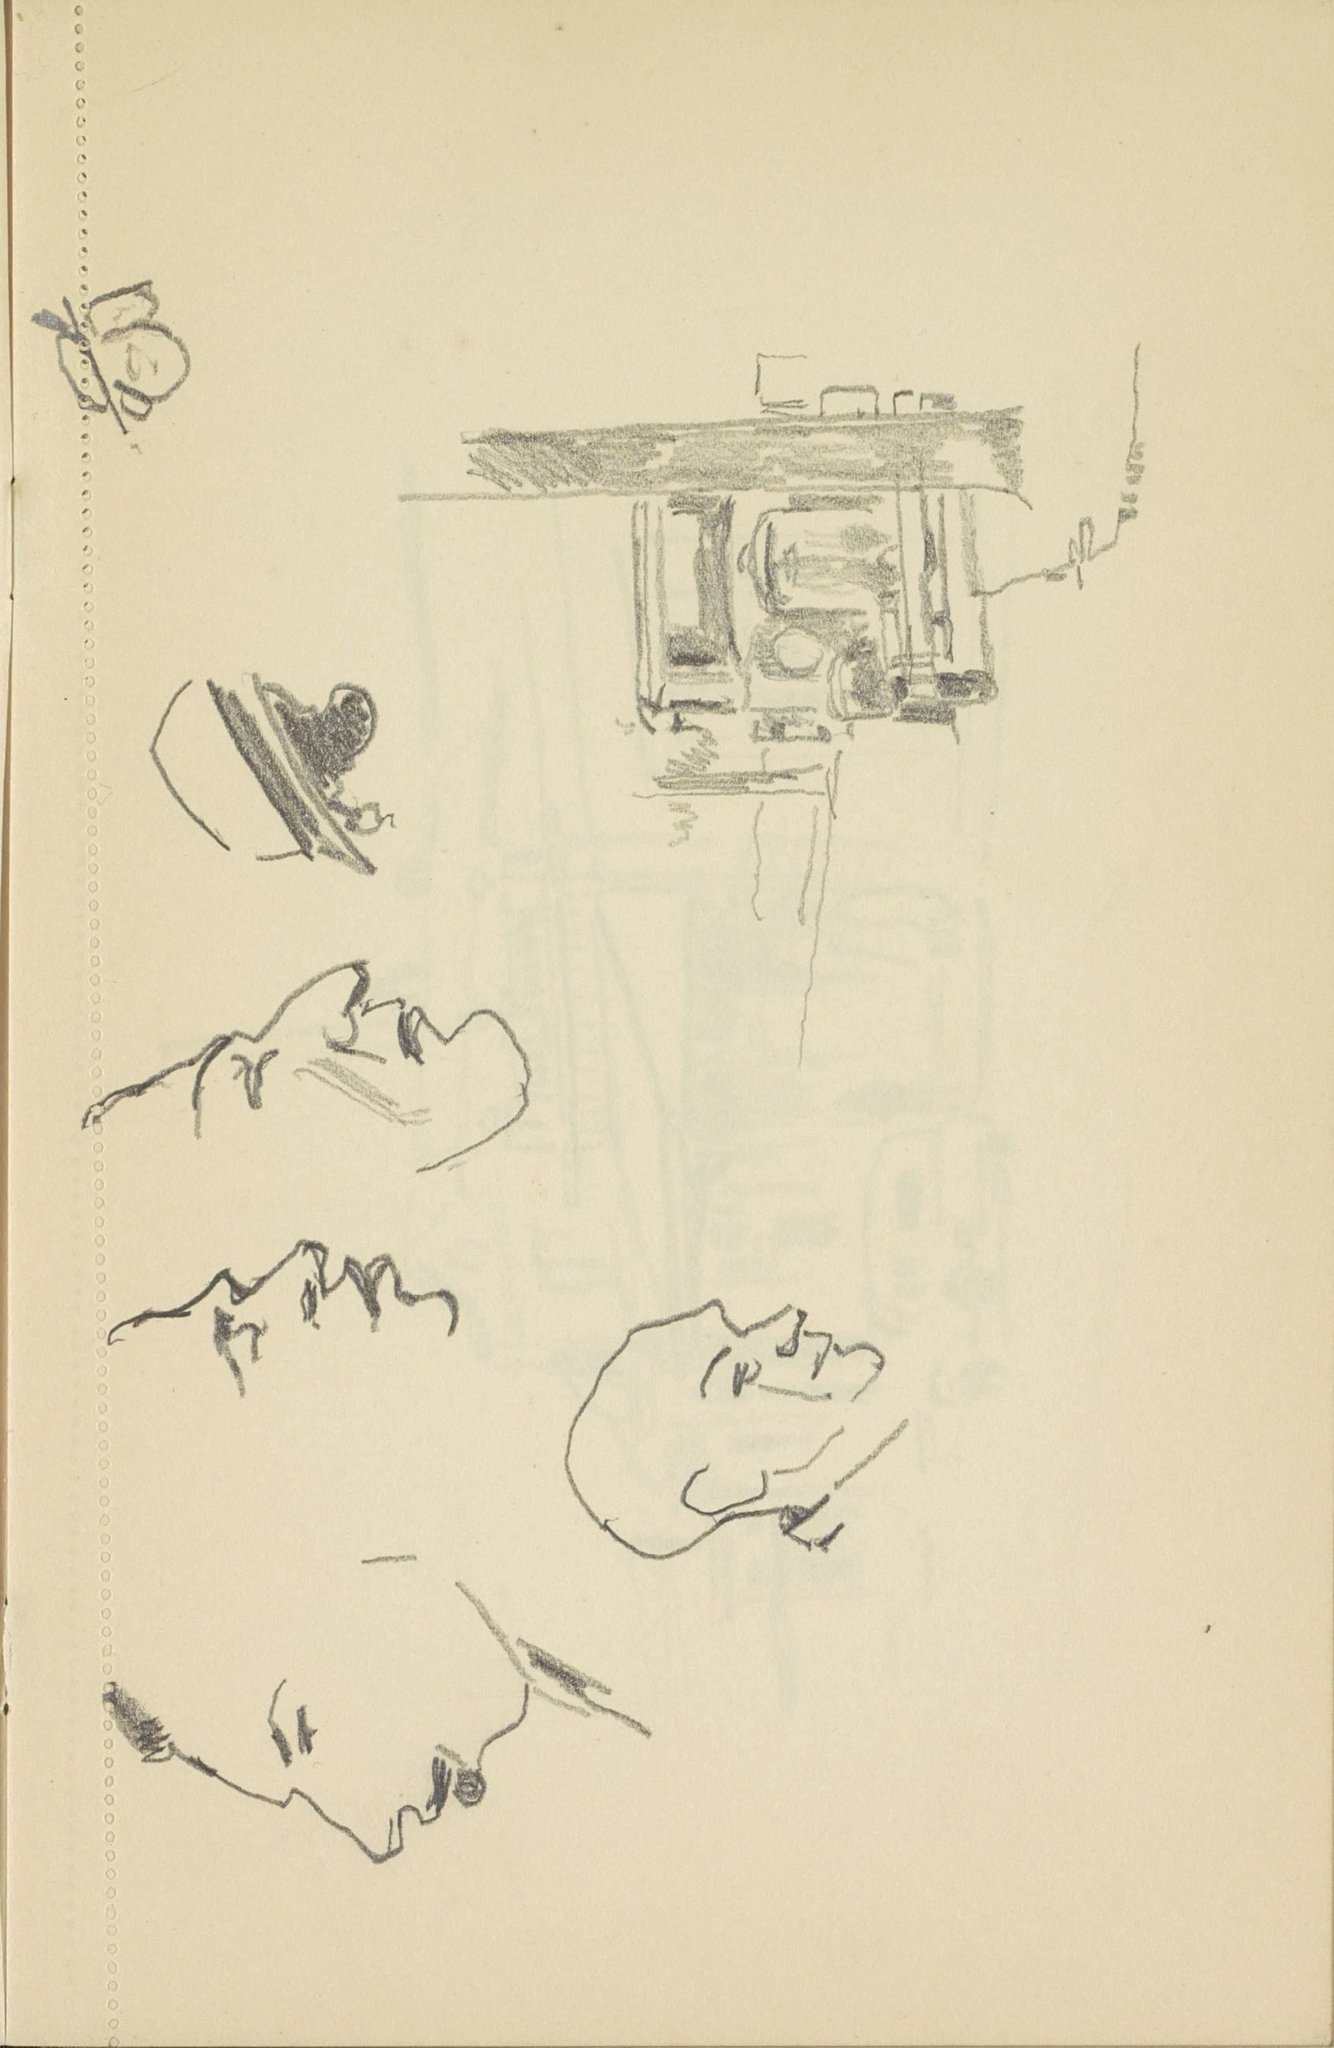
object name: sketchbook leaf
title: Auto bij een boom en koppen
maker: cornelis vreedenburgh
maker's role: draughtsman, print maker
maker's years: 1880-1946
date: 1890-1946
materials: paper, pencil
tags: head (human), automobile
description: Blad 26 recto uit een schetsboek met 73 bladen.